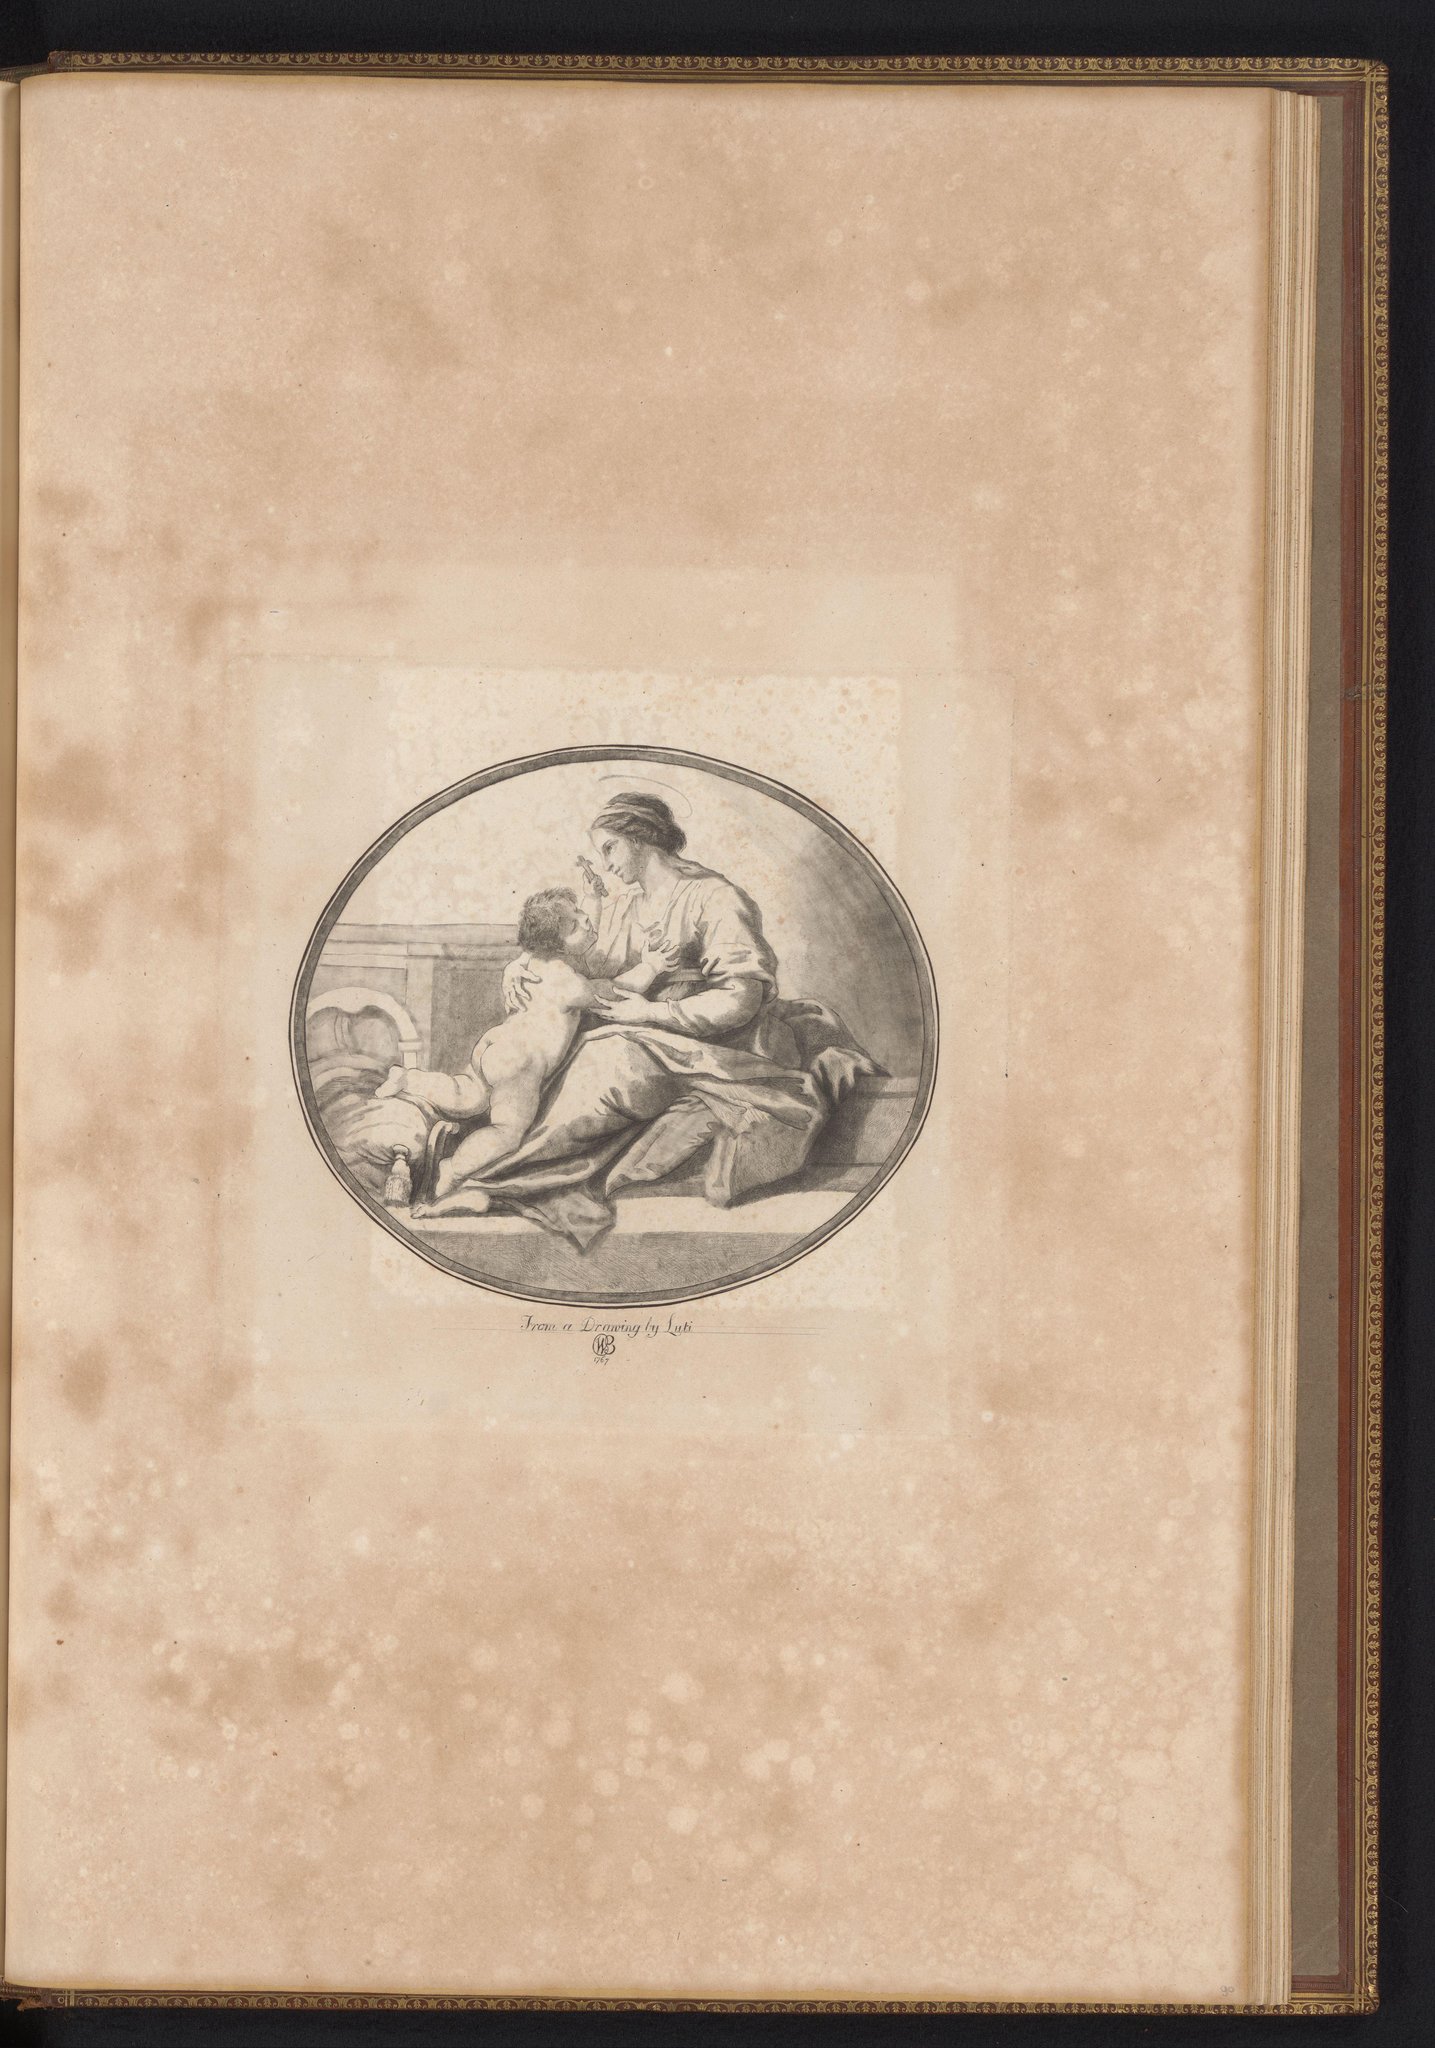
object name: print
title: Maria met Kind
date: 1767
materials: paper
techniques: etching, rocker stamped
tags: madonna: i.e. mary with the christ-child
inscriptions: date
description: De maagd Maria zittende op een stenen bank. Ze omhelst het Christuskind die met een kruis in zijn handen naar haar toekomt. Zijn linkerbeen ligt op een kussen. De prent maakt deel uit van een album.